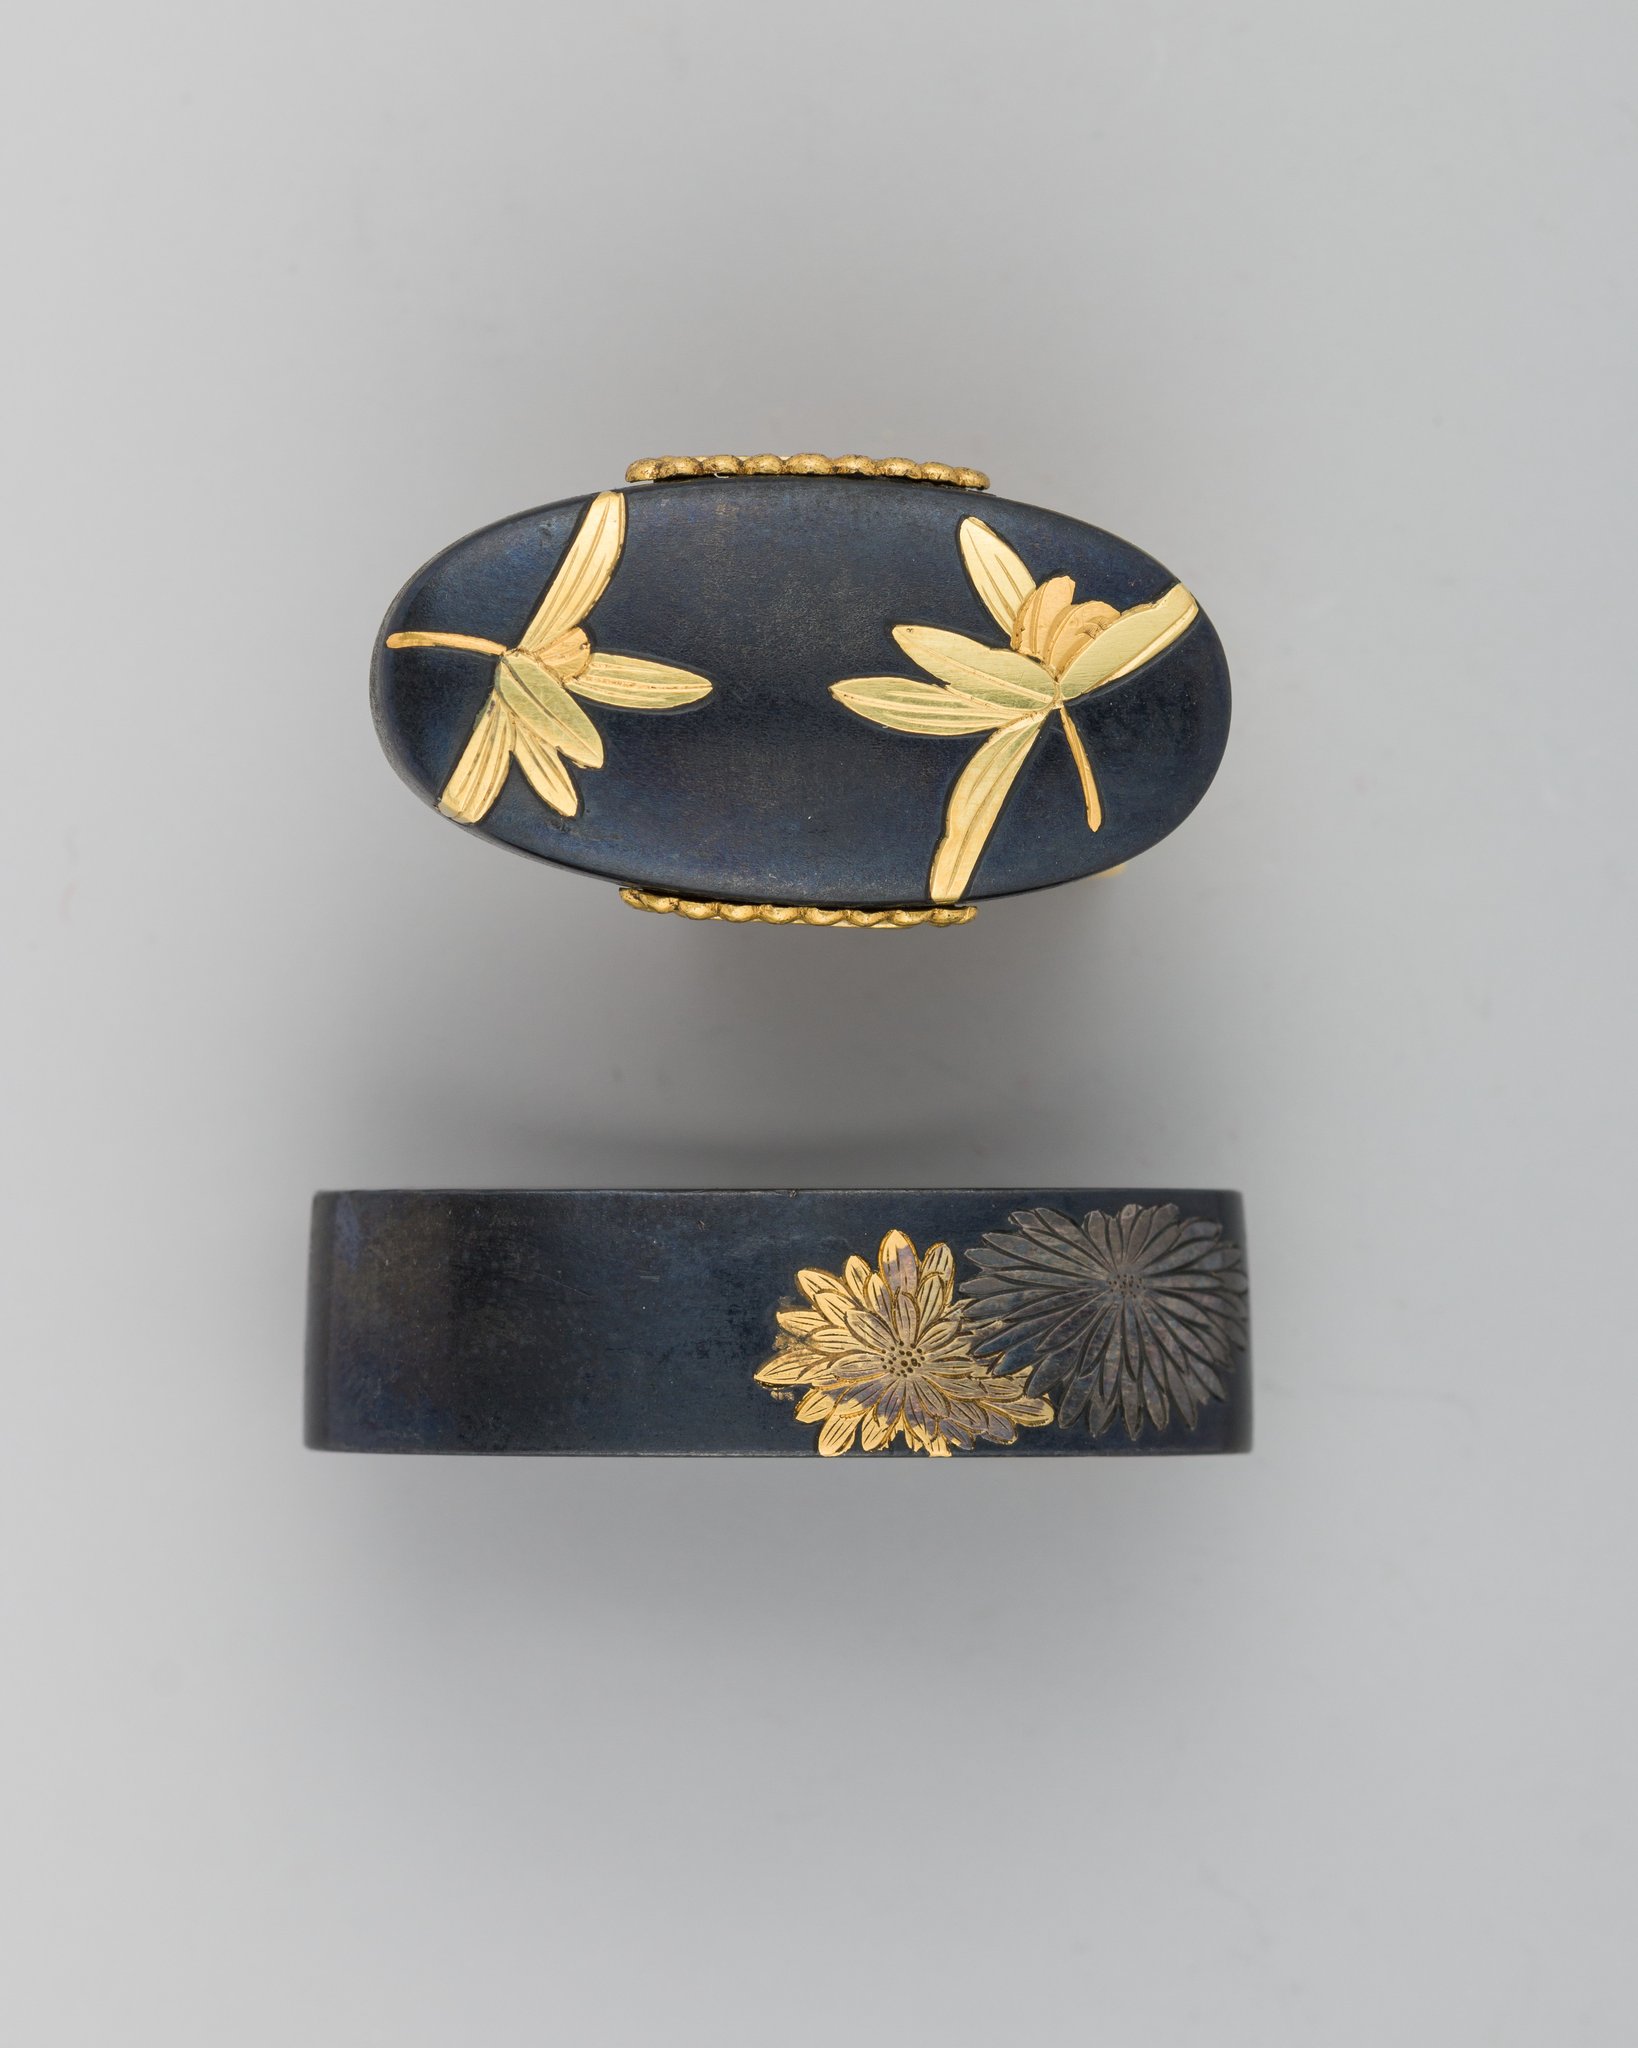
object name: sword hilt collar and pommel fuchigashira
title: Sword-Hilt Collar and Pommel (Fuchigashira)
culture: japanese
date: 1789-1876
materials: gold alloy, gold, silver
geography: japan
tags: flowers